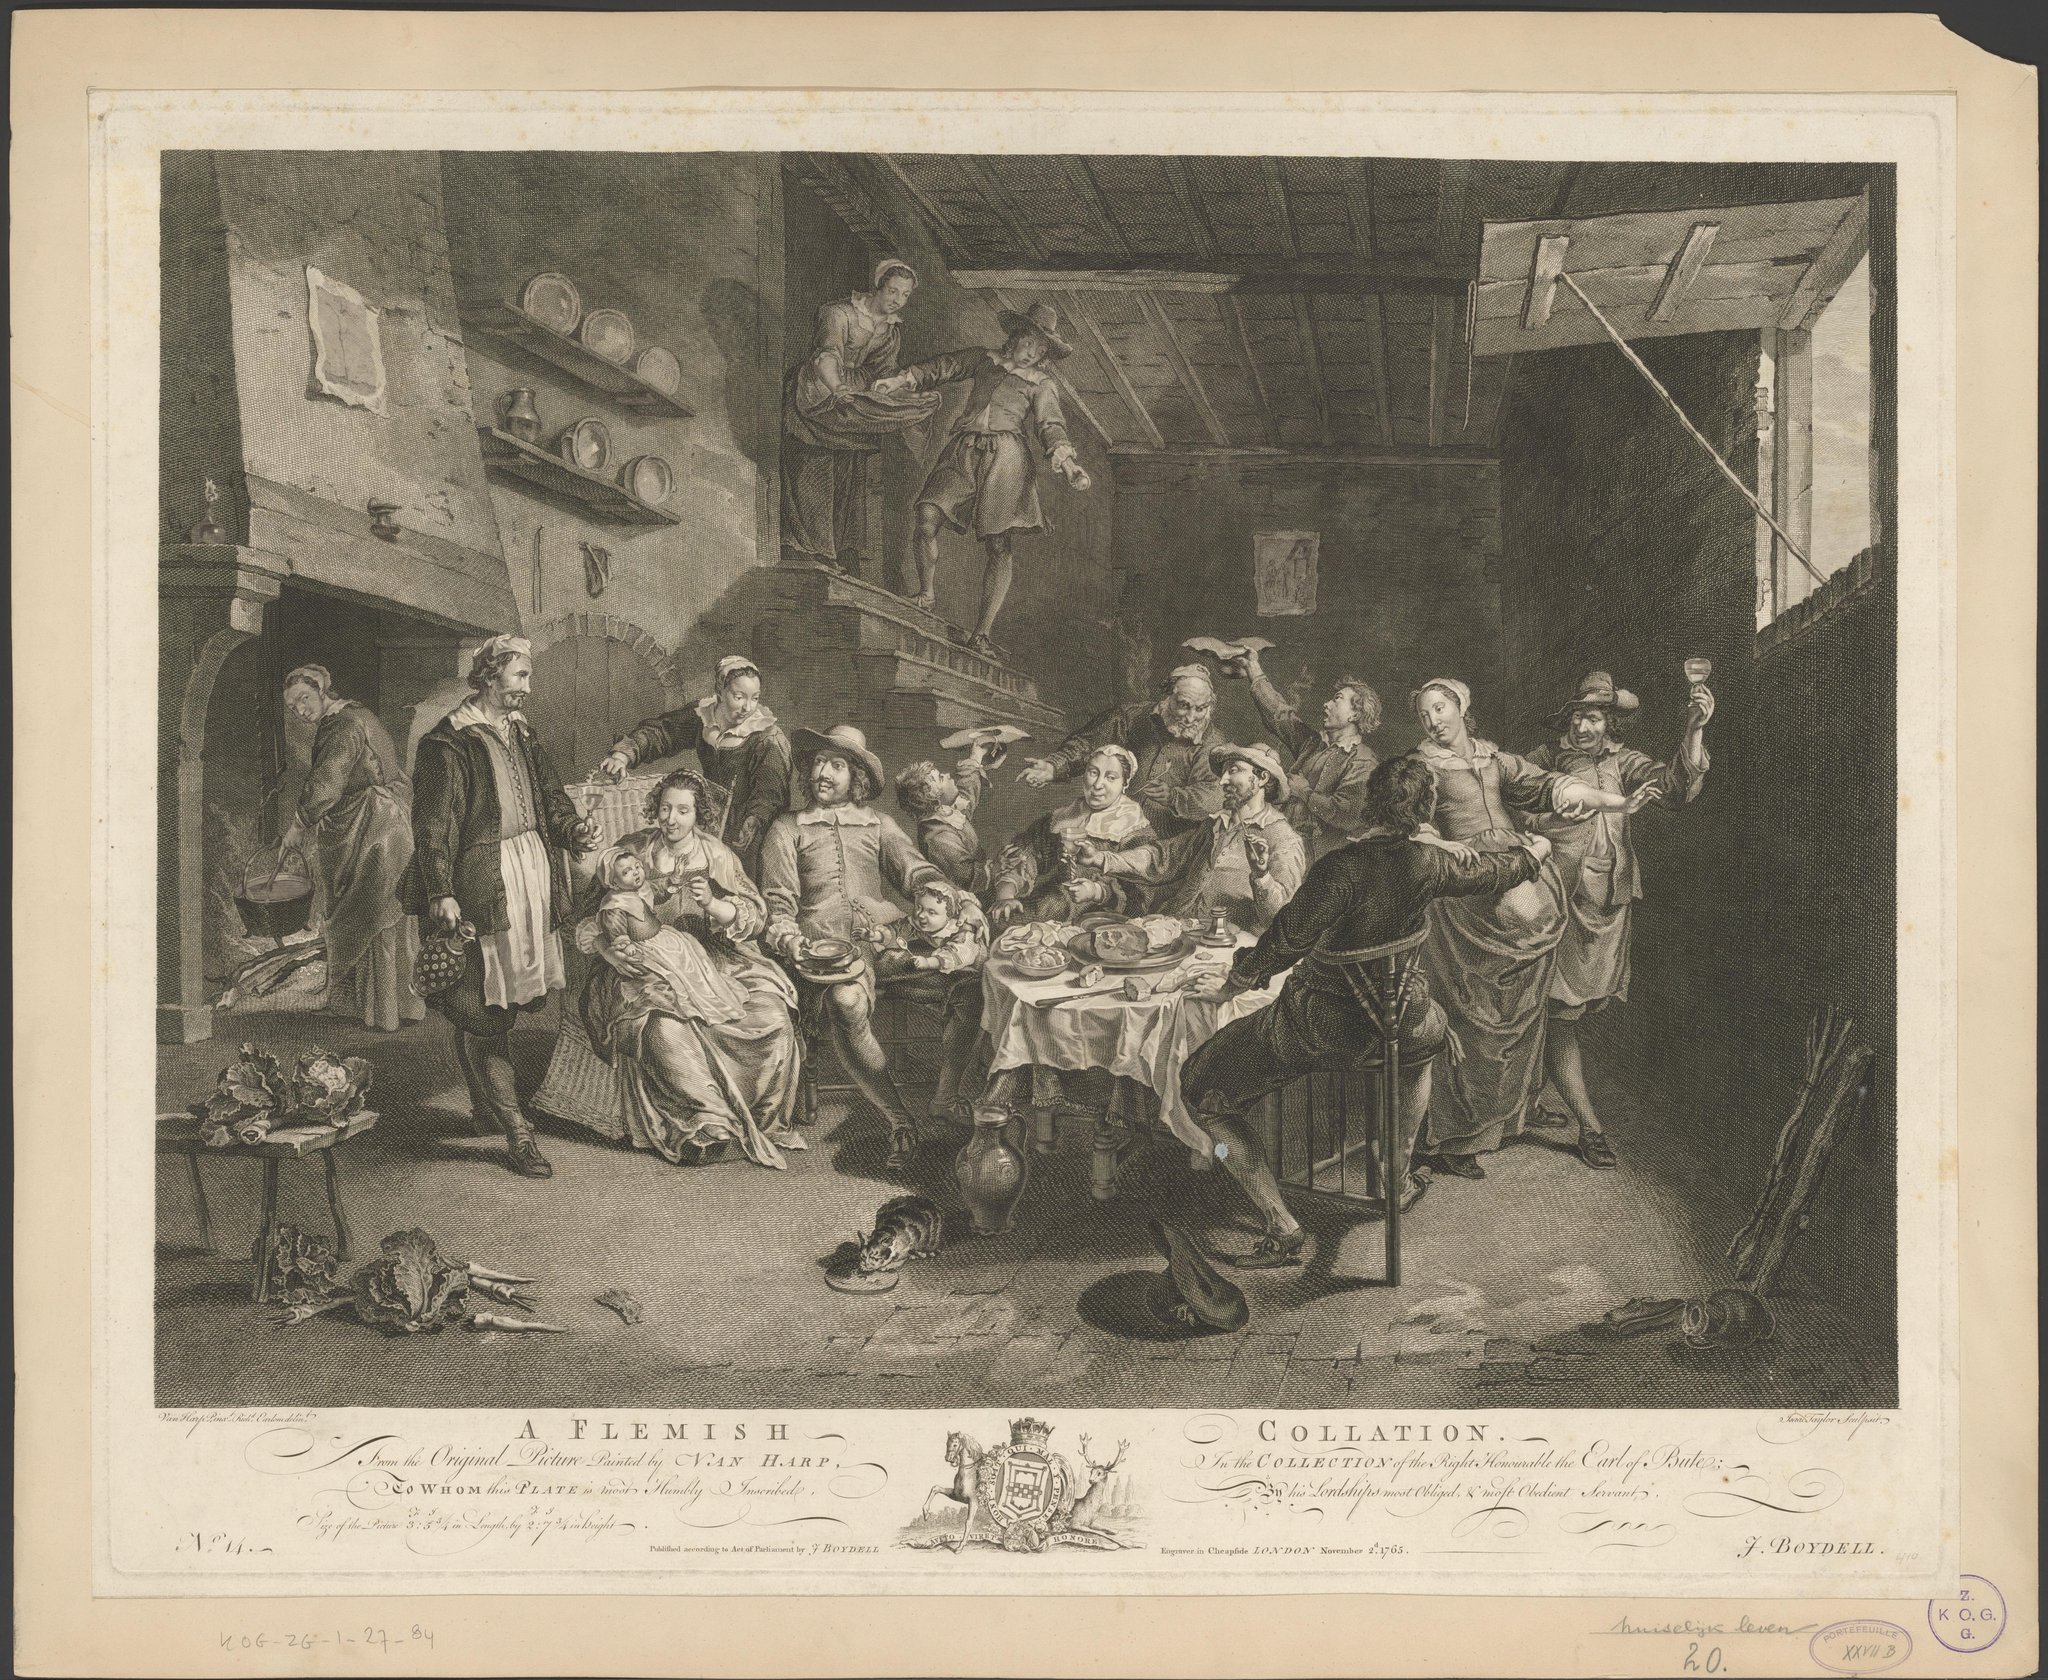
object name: print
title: Vlaamse maaltijd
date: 1765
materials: paper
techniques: engraving, etching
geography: england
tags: kitchen, family life at home, kitchen-maid, kitchen servant, dining-room, house personnel, servants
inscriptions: collector's mark, collector's mark: Lugt 1641